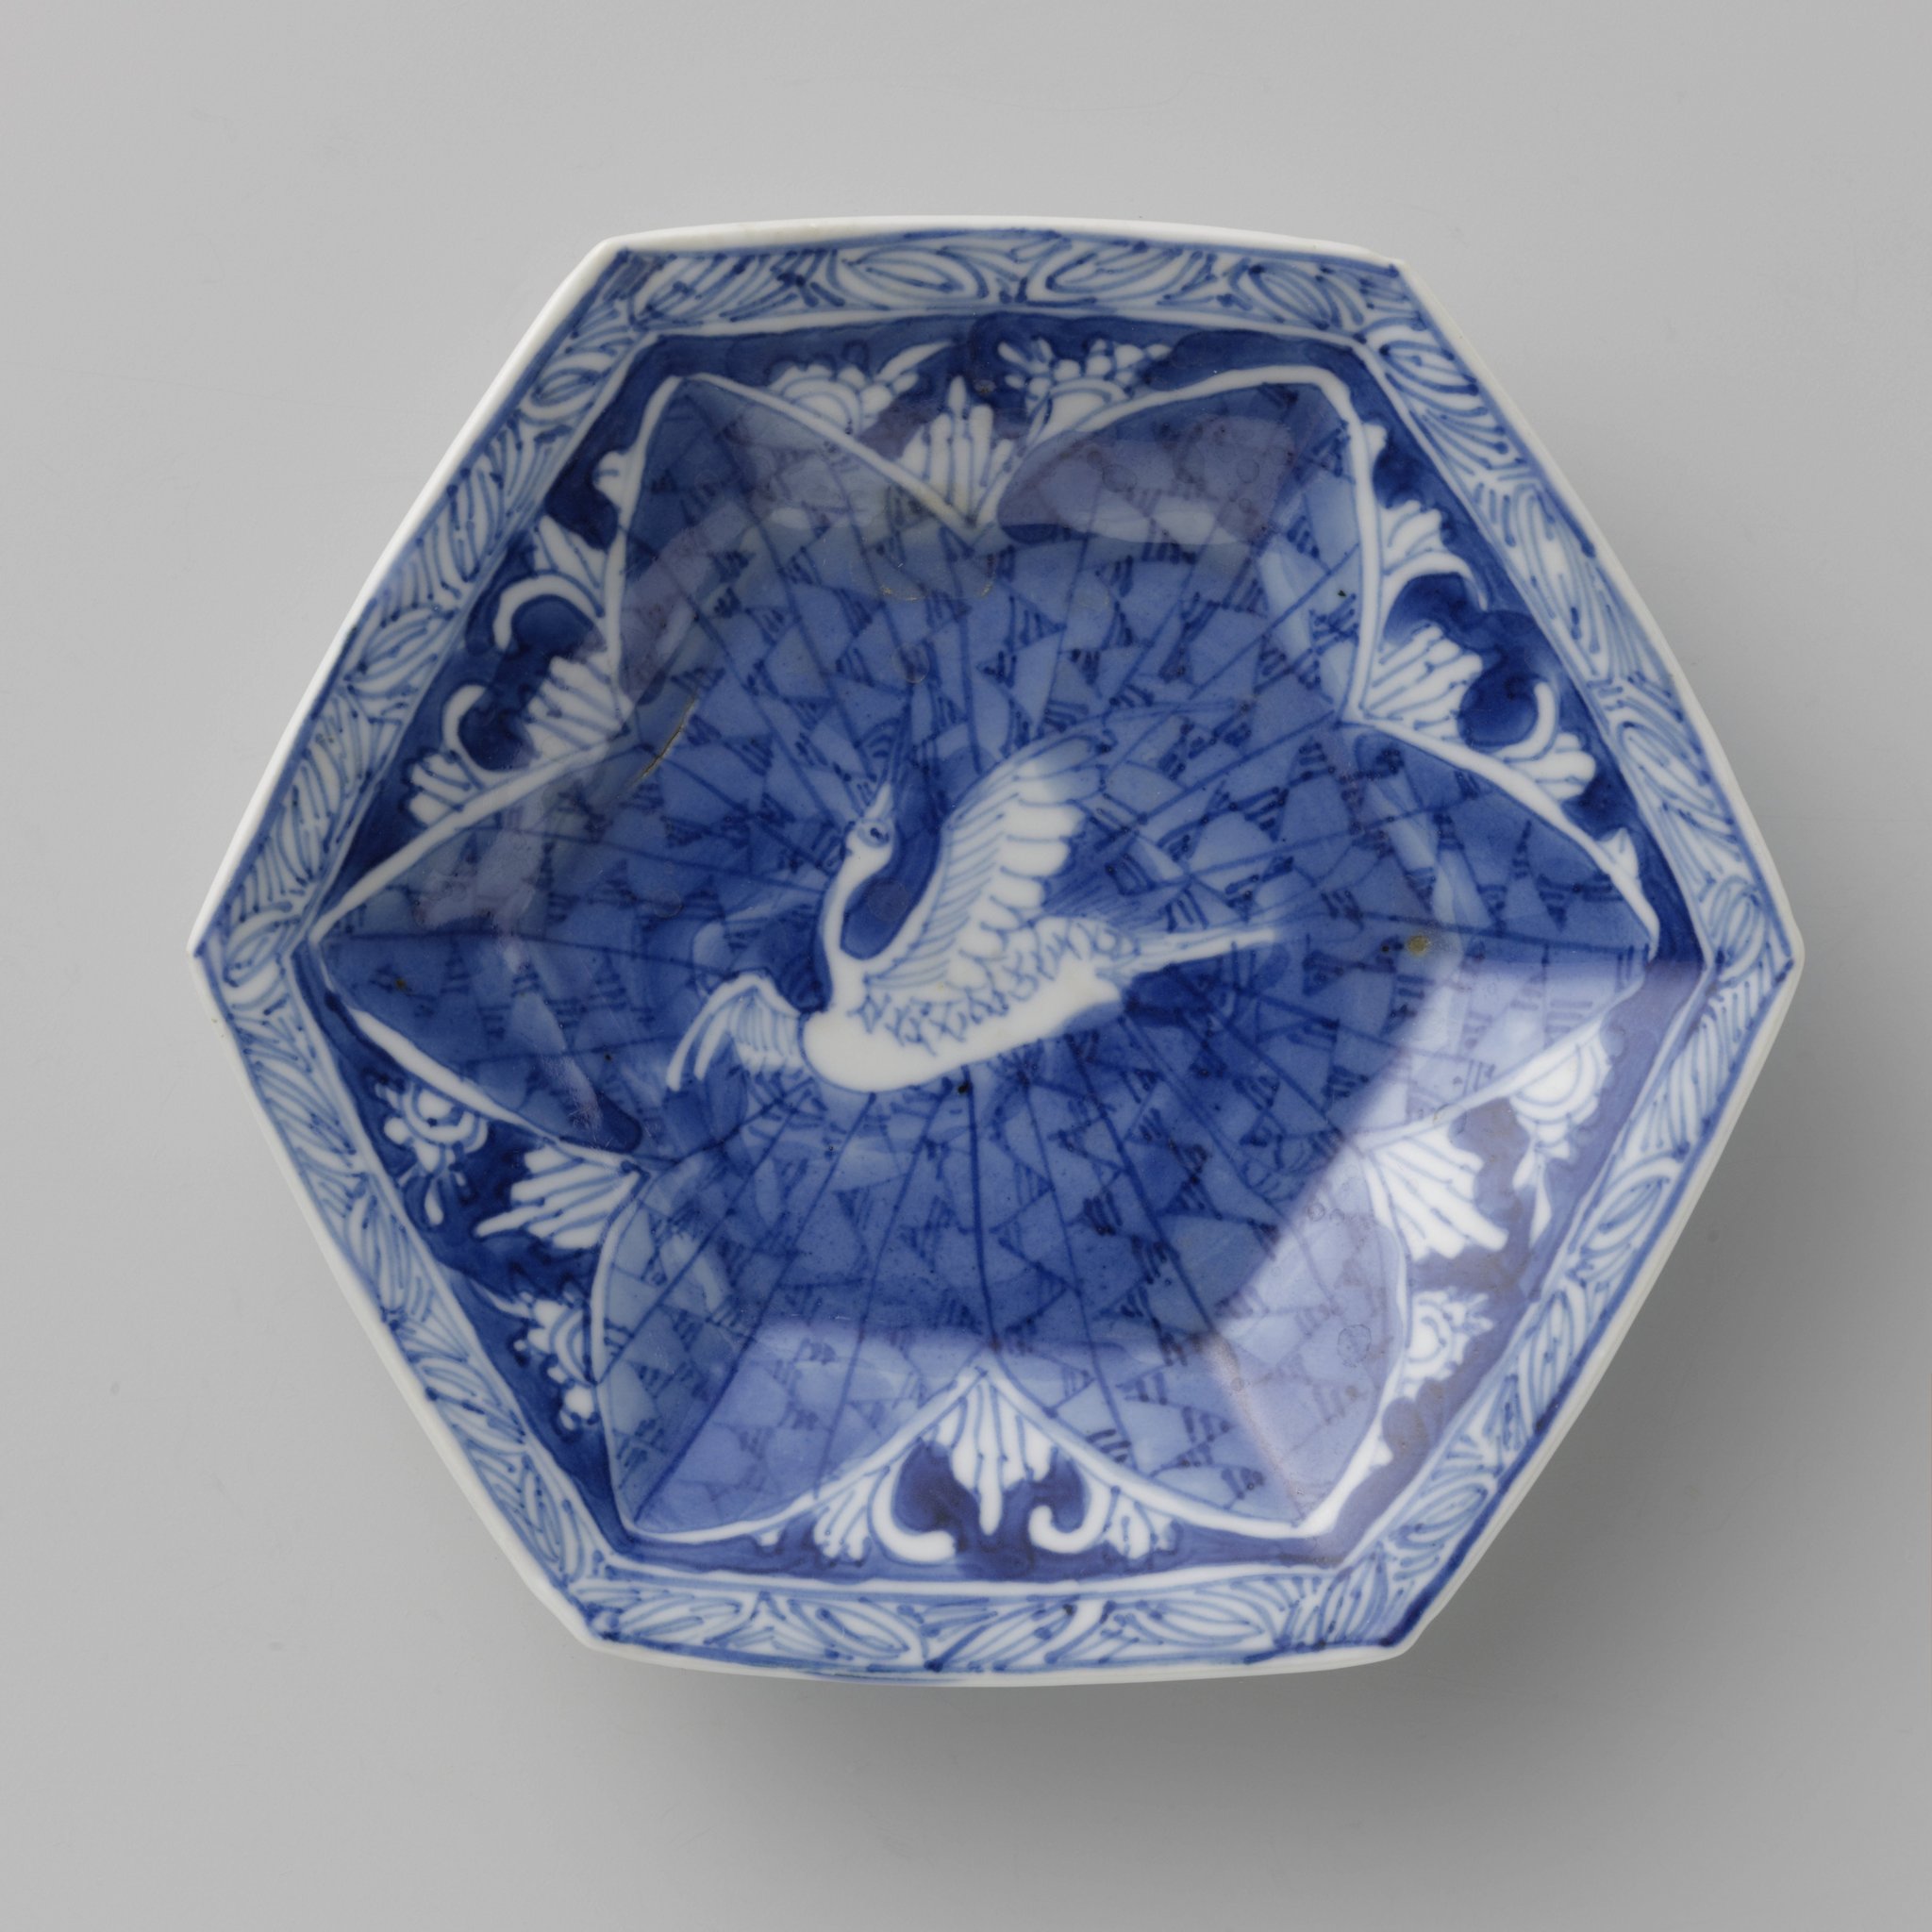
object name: platter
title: Hexagonal saucer with star-shaped panel with a flying crane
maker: Anonymous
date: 1700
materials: cobalt, glaze, paint, porcelain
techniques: firing, forming, turning, vitrification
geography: china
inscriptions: mark: ‘福’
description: Schotel van porselein, zeshoekig, beschilderd in onderglazuurblauw met lotusranken en een stervormig veld met een vliegende kraanvogel op een achtergrond van gebarsten ijs. Gemerkt op de bodem met een vierkant 'Fu'-merk in een dubbele cirkel.